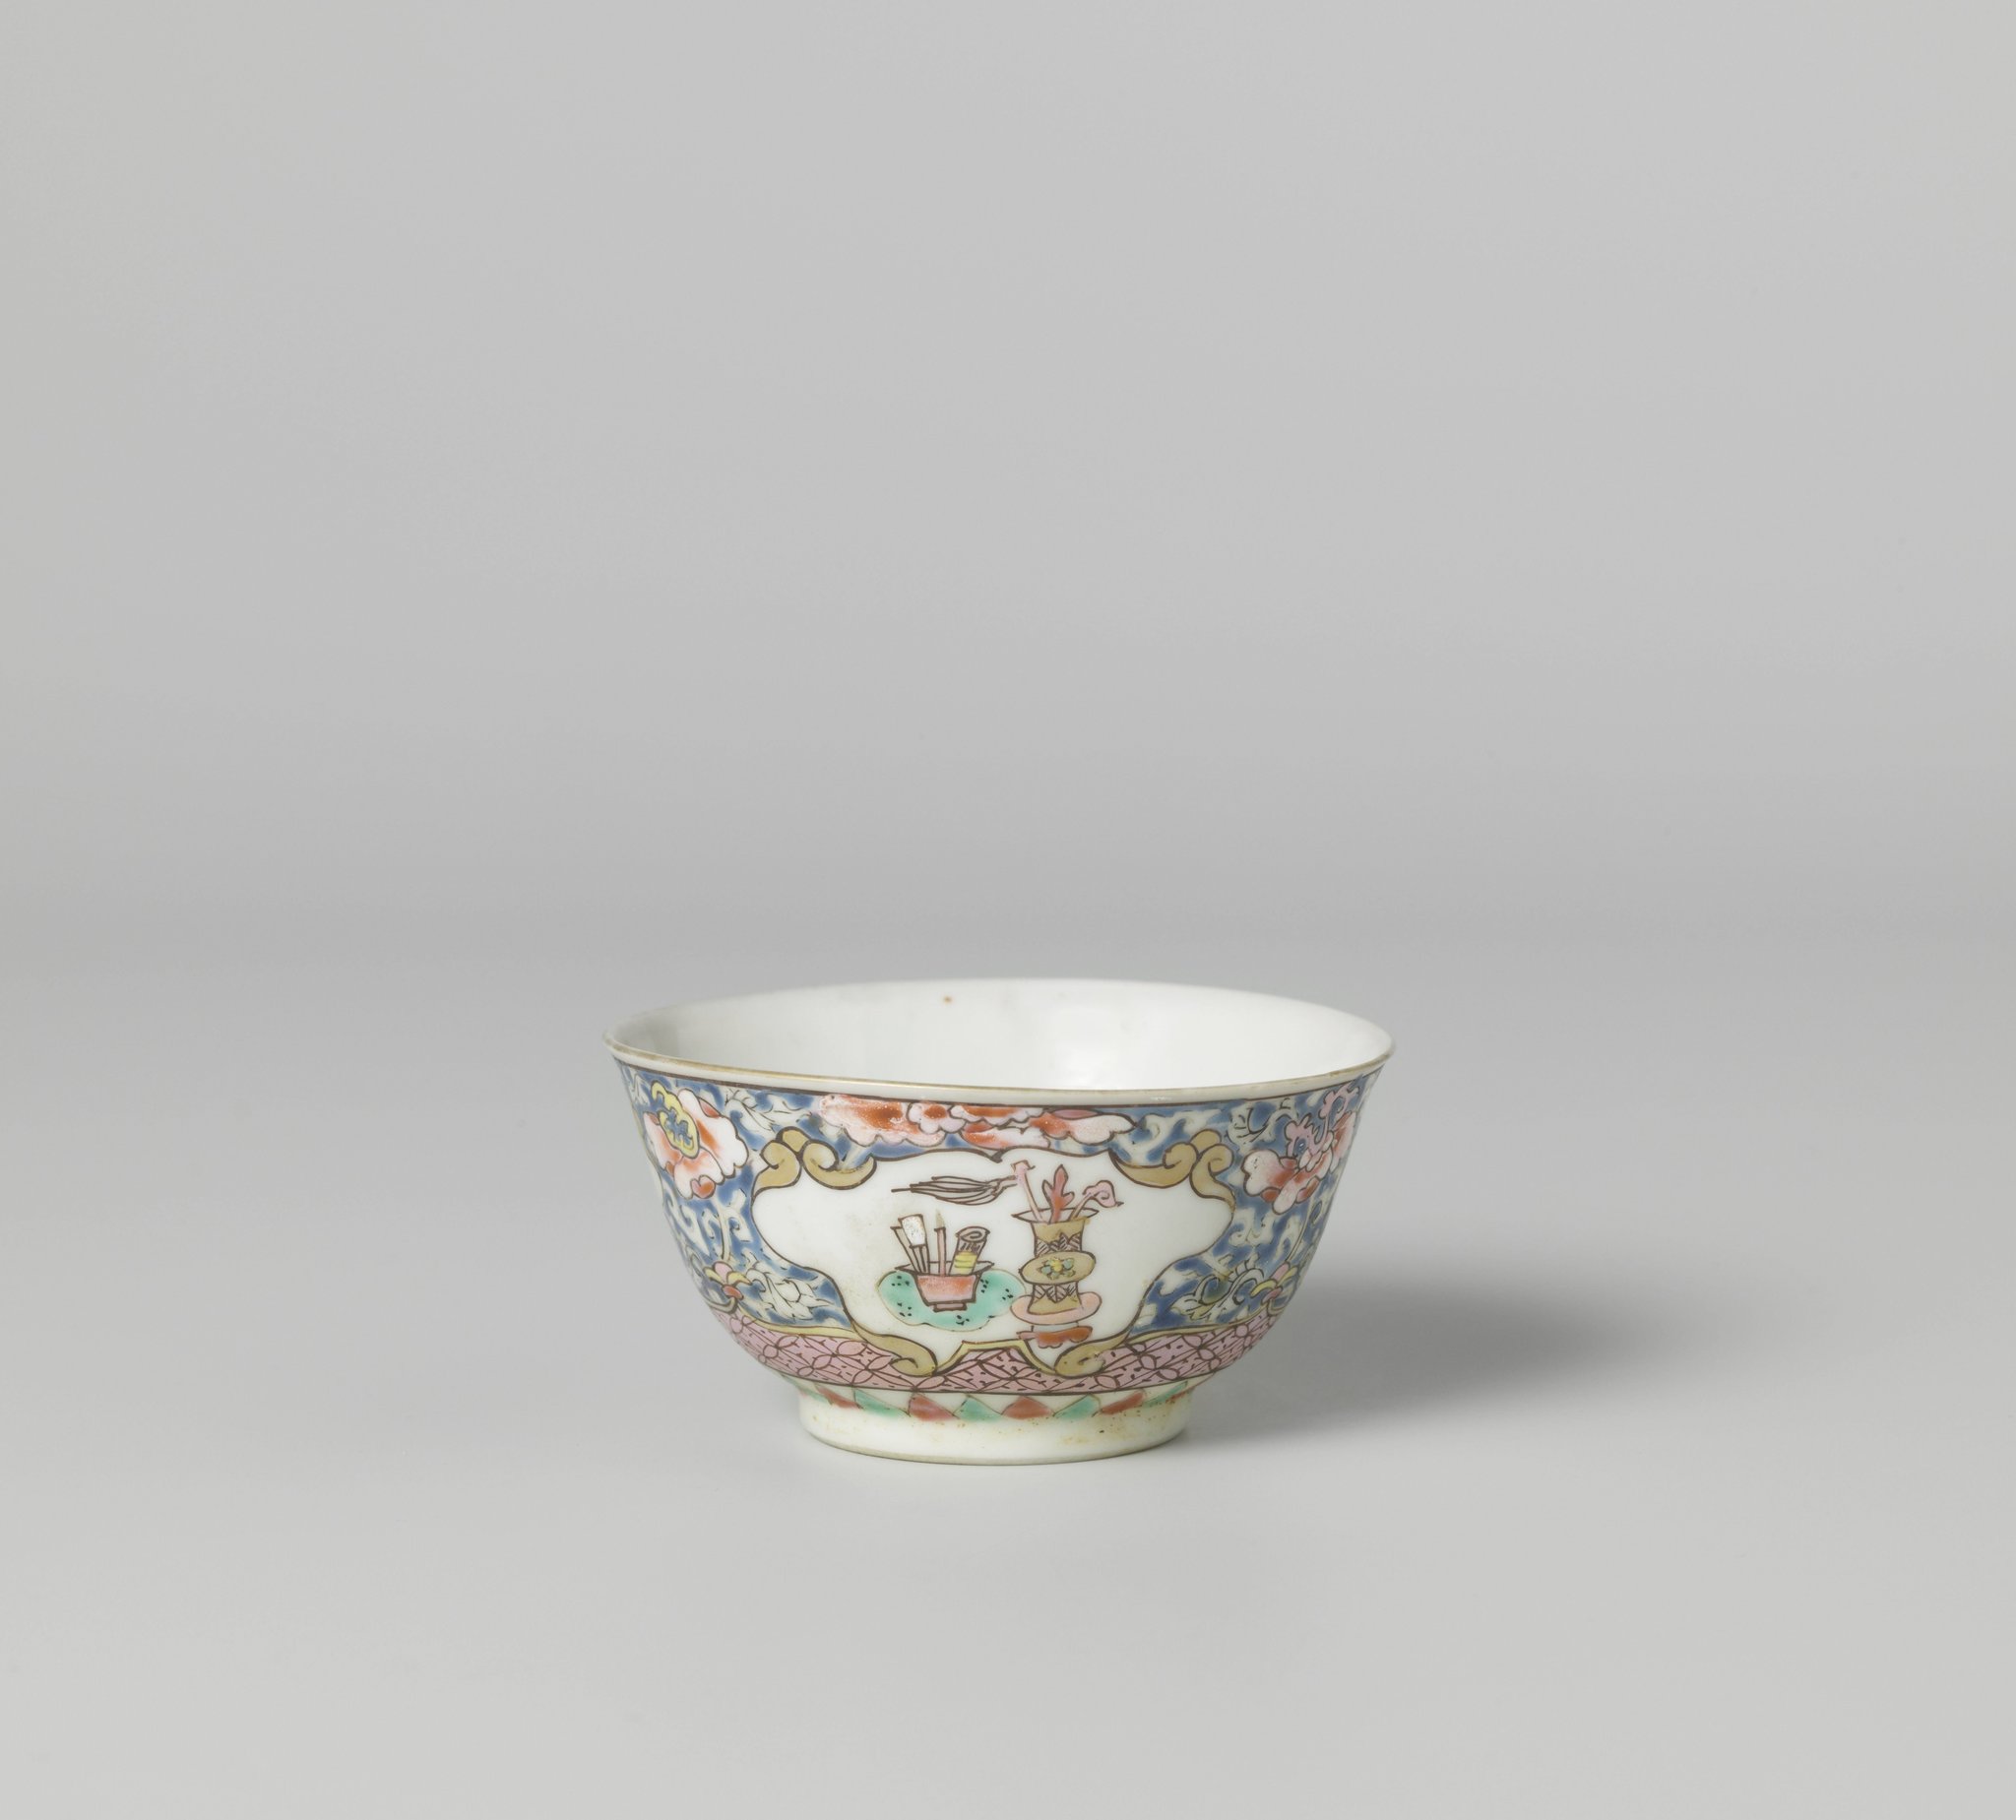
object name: kop en schotel, kop en schotel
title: Bell-shaped cup with antiquities in panels on a ground of floral scrolls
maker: Anonymous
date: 1800-1899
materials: glaze, gold, paint, porcelain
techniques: firing, gilding, turning, vitrification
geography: china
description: Klokvormige kop van porselein, beschilderd op het glazuur in blauw, rood, roze, turquoise, geel, roze en goud. Een medaillon in een driehoek met servetwerk, daaromheen drie cartouches met antiquiteiten (fruitschaal met vingercitroen, vazen met pauwenveren en koraal, wierookbrander, scepter, objecten van een geleerde etc.) tegen een achtergrond van bloemranken afgebeeld. Famille rose.